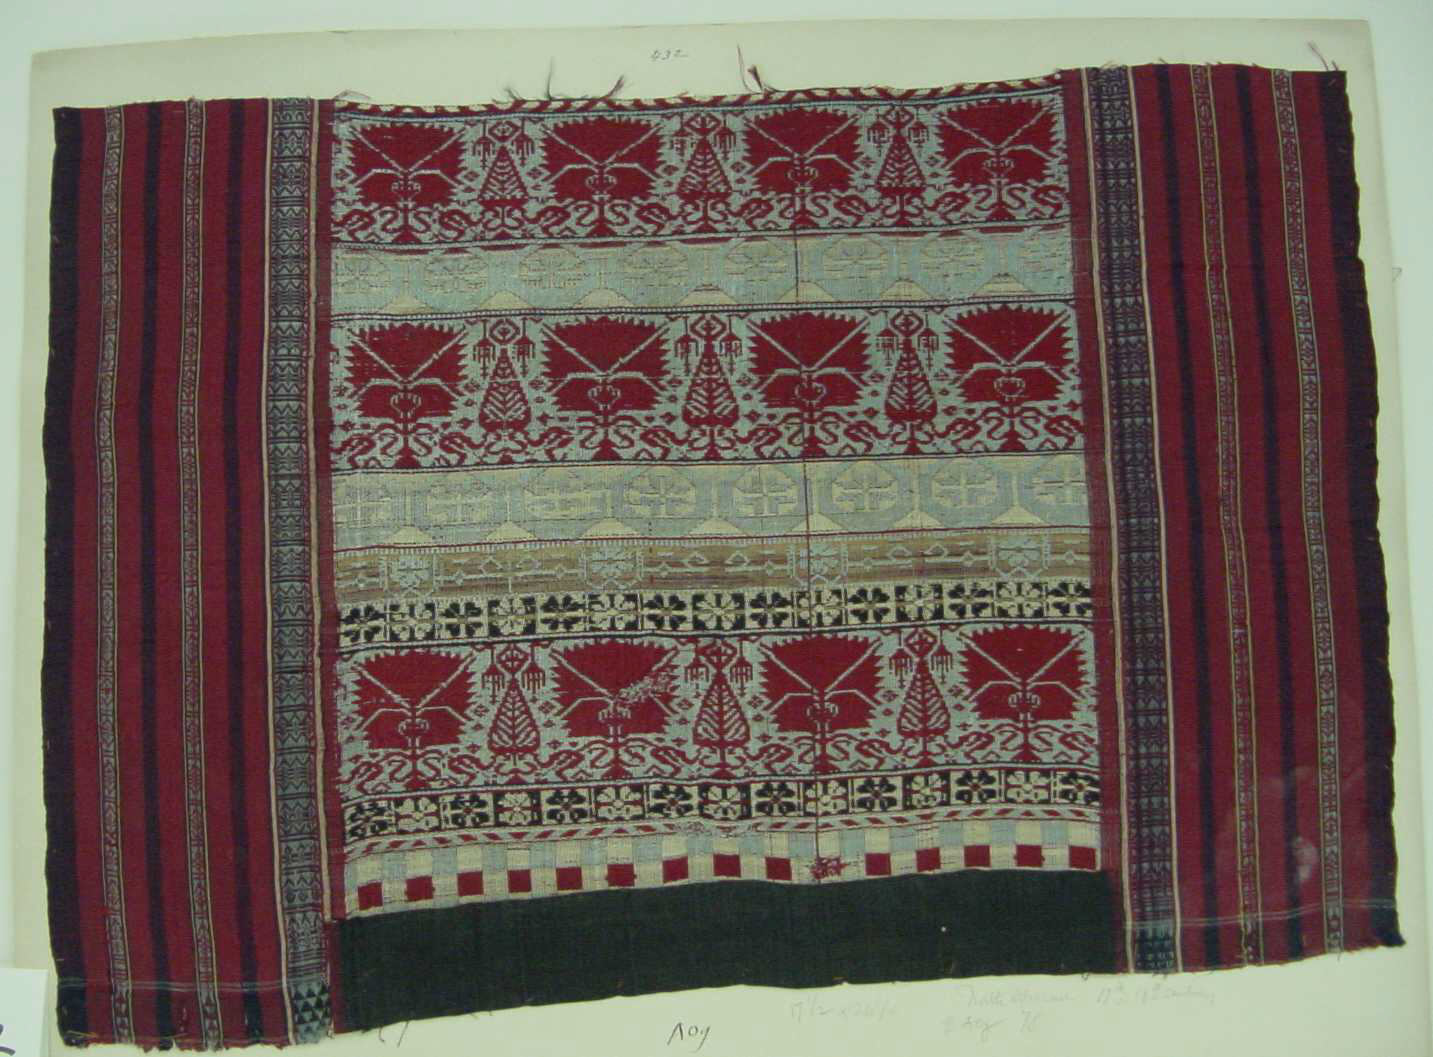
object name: textile fragment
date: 1701-1800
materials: silk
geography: north africa